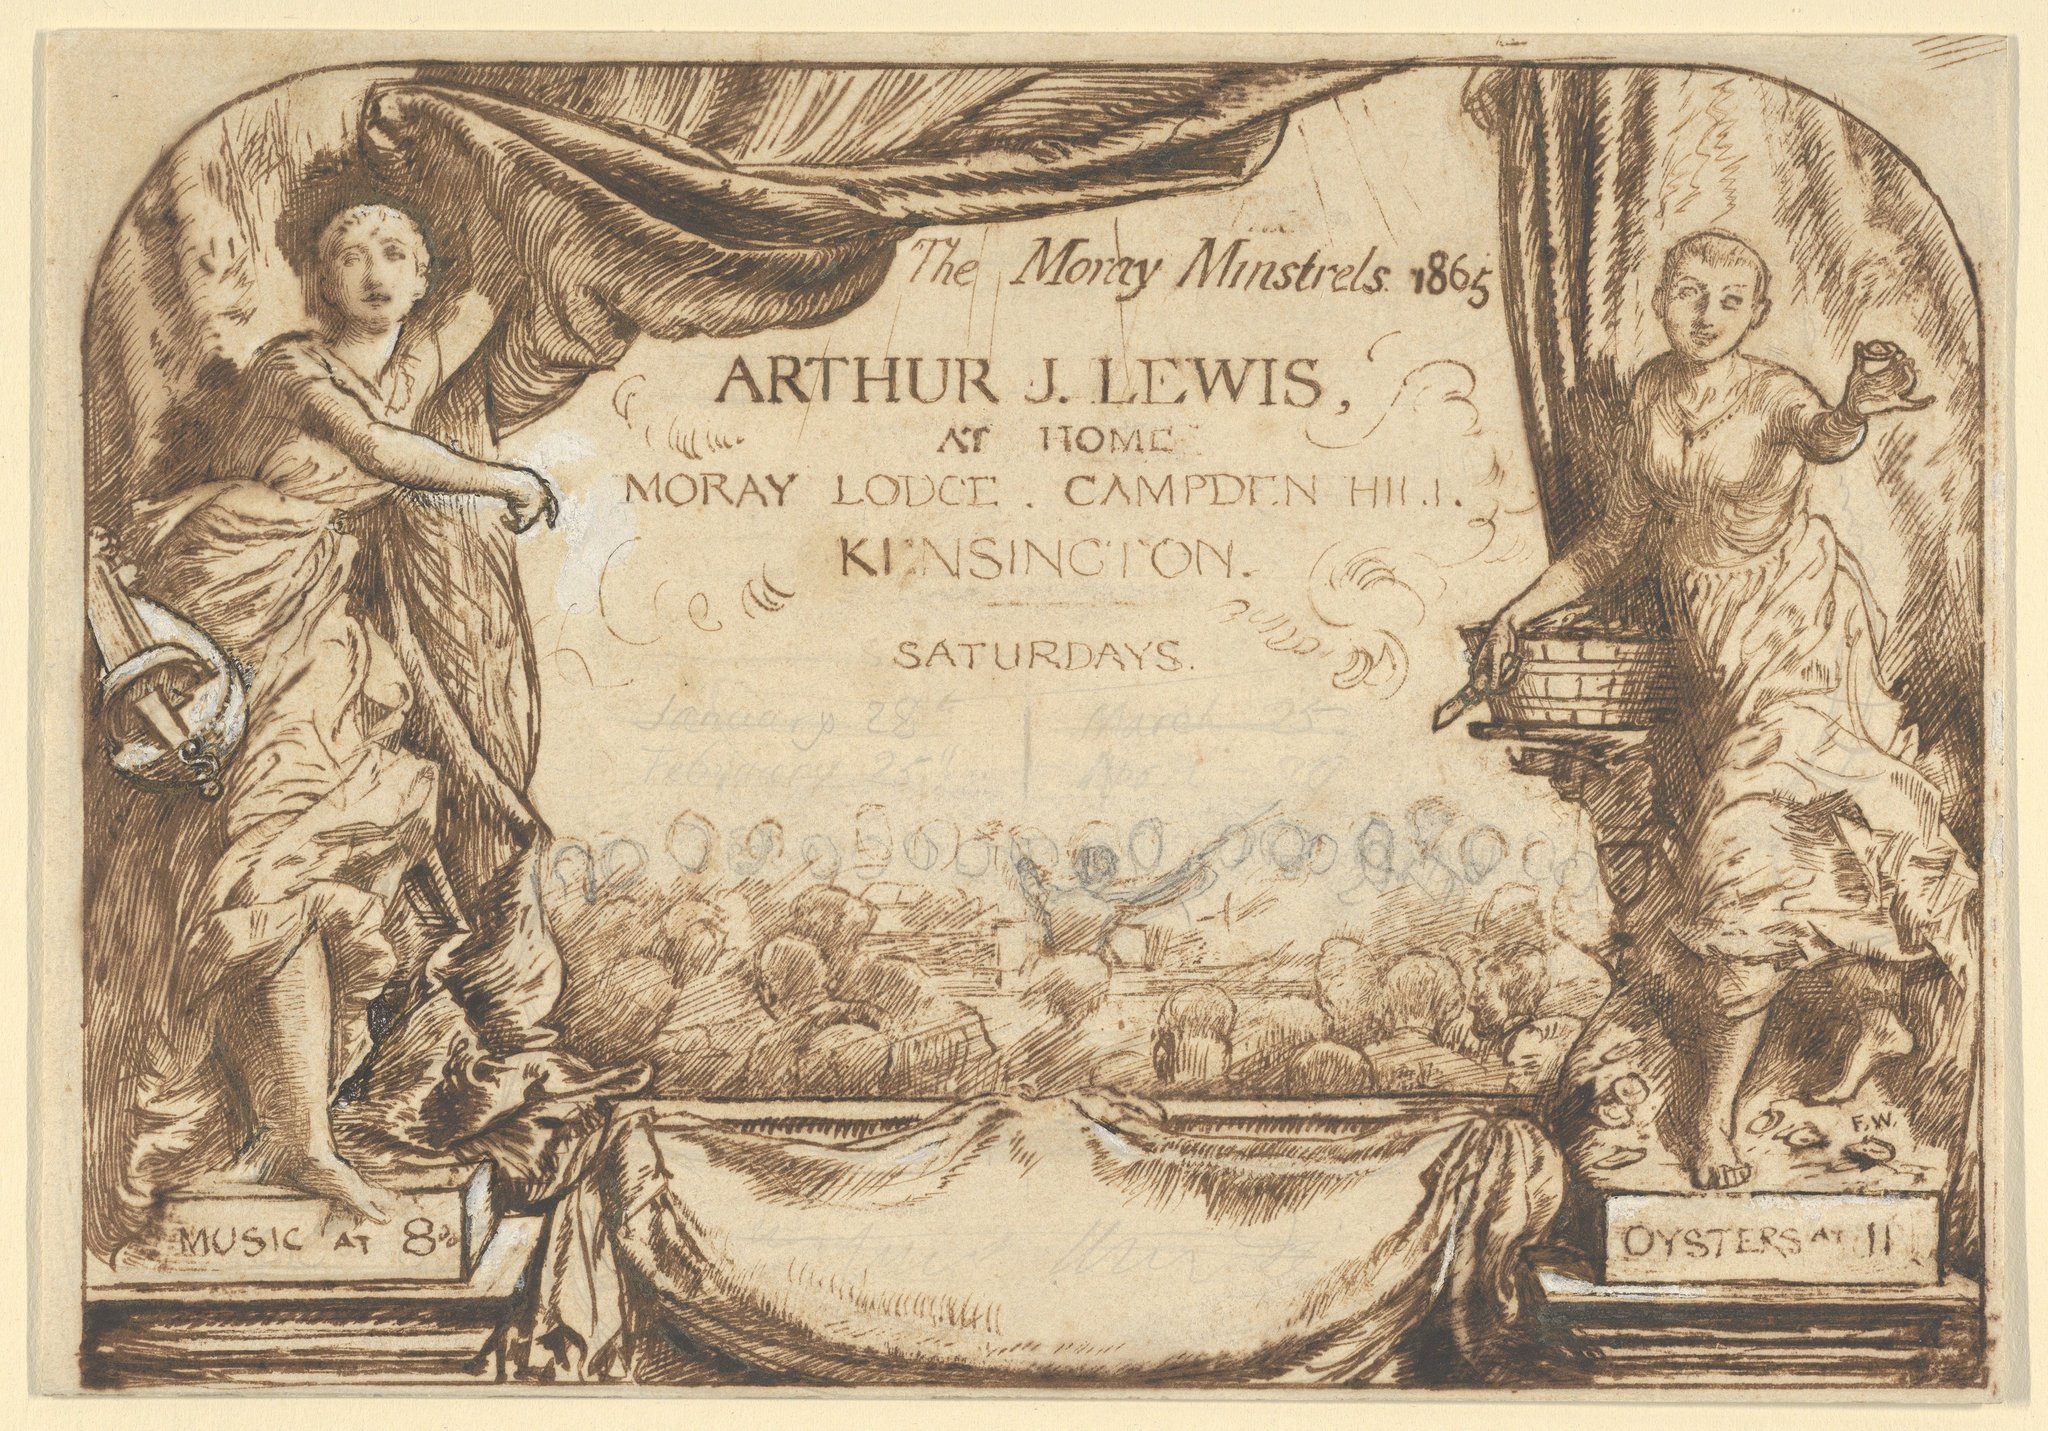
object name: drawing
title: The Moray Minstrels (Design for Invitation card of Arthur James Lewis)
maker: frederick walker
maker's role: artist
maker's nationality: british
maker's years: 1840-1875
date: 1865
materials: gouache, graphite, ink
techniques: pen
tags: men,women